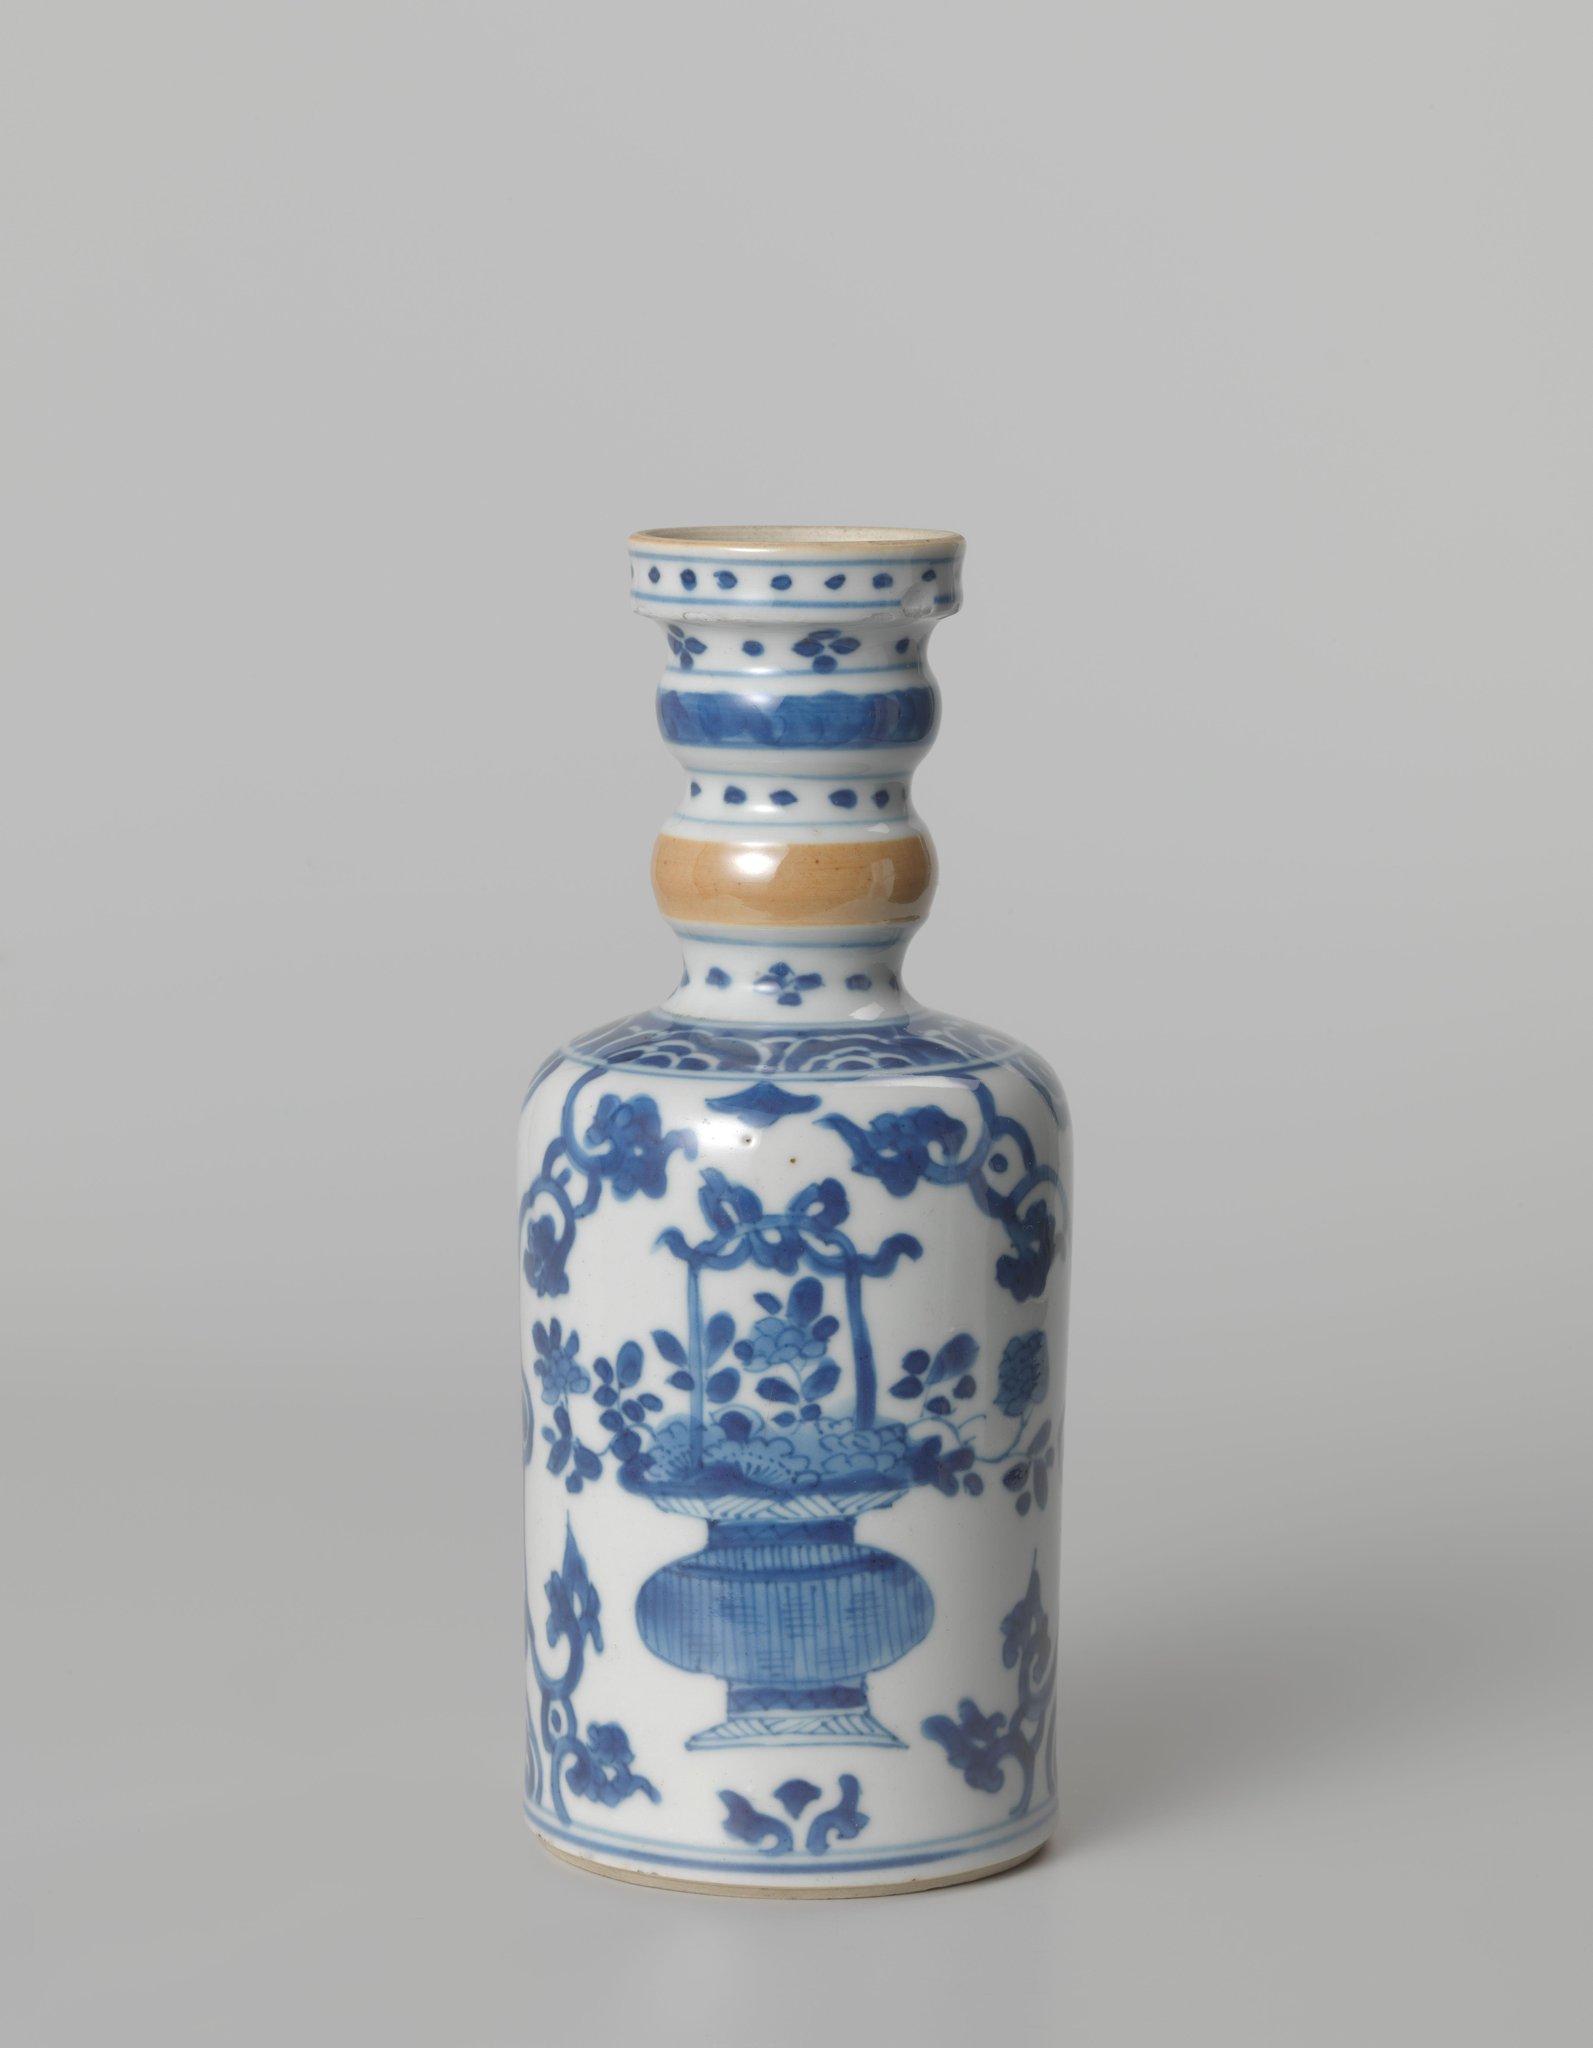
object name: bottle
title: Bottle vase with flower baskets and floral scrolls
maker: Anonymous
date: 1680-1720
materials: cobalt, glaze, paint, porcelain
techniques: firing, turning, vitrification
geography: china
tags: flowers ~ ornament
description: AK-NM-6730 Twee vazen • Blauw-wit Kangxi-porselein • Onderdeel van Royers porseleincollectie • Oorspronkelijk drie exemplaren (Inventaris Van der Kellen 1876) Het is mij niet duidelijk hoe de vorm van dit flesje met de verdikkingen in de hals en de opstaande lip verklaard kunnen worden. Het brengt in de verte porseleinen waterpijpstandaards in gedachte, maar die hebben een echt ‘kommetje’ als mondstuk en een boller lichaam. Misschien is deze ingewikkelde hals alleen voor de sier op deze manier gemaakt. De mand met bloemen is een element dat weliswaar al op Kraakporselein voorkomt (zie porselein uit de San Diego, 1600) maar op deze manier, met het staande hengsel, pas in de Kangxi-tijd algemeen wordt. De bloemenmanden op Kraakporselein hebben overhet algemeen een andere vorm. Een identiek exemplaar bevindt zich in het British Museum, Londen (Franks.286) en in de collectie van Kasteel Keukenhof.